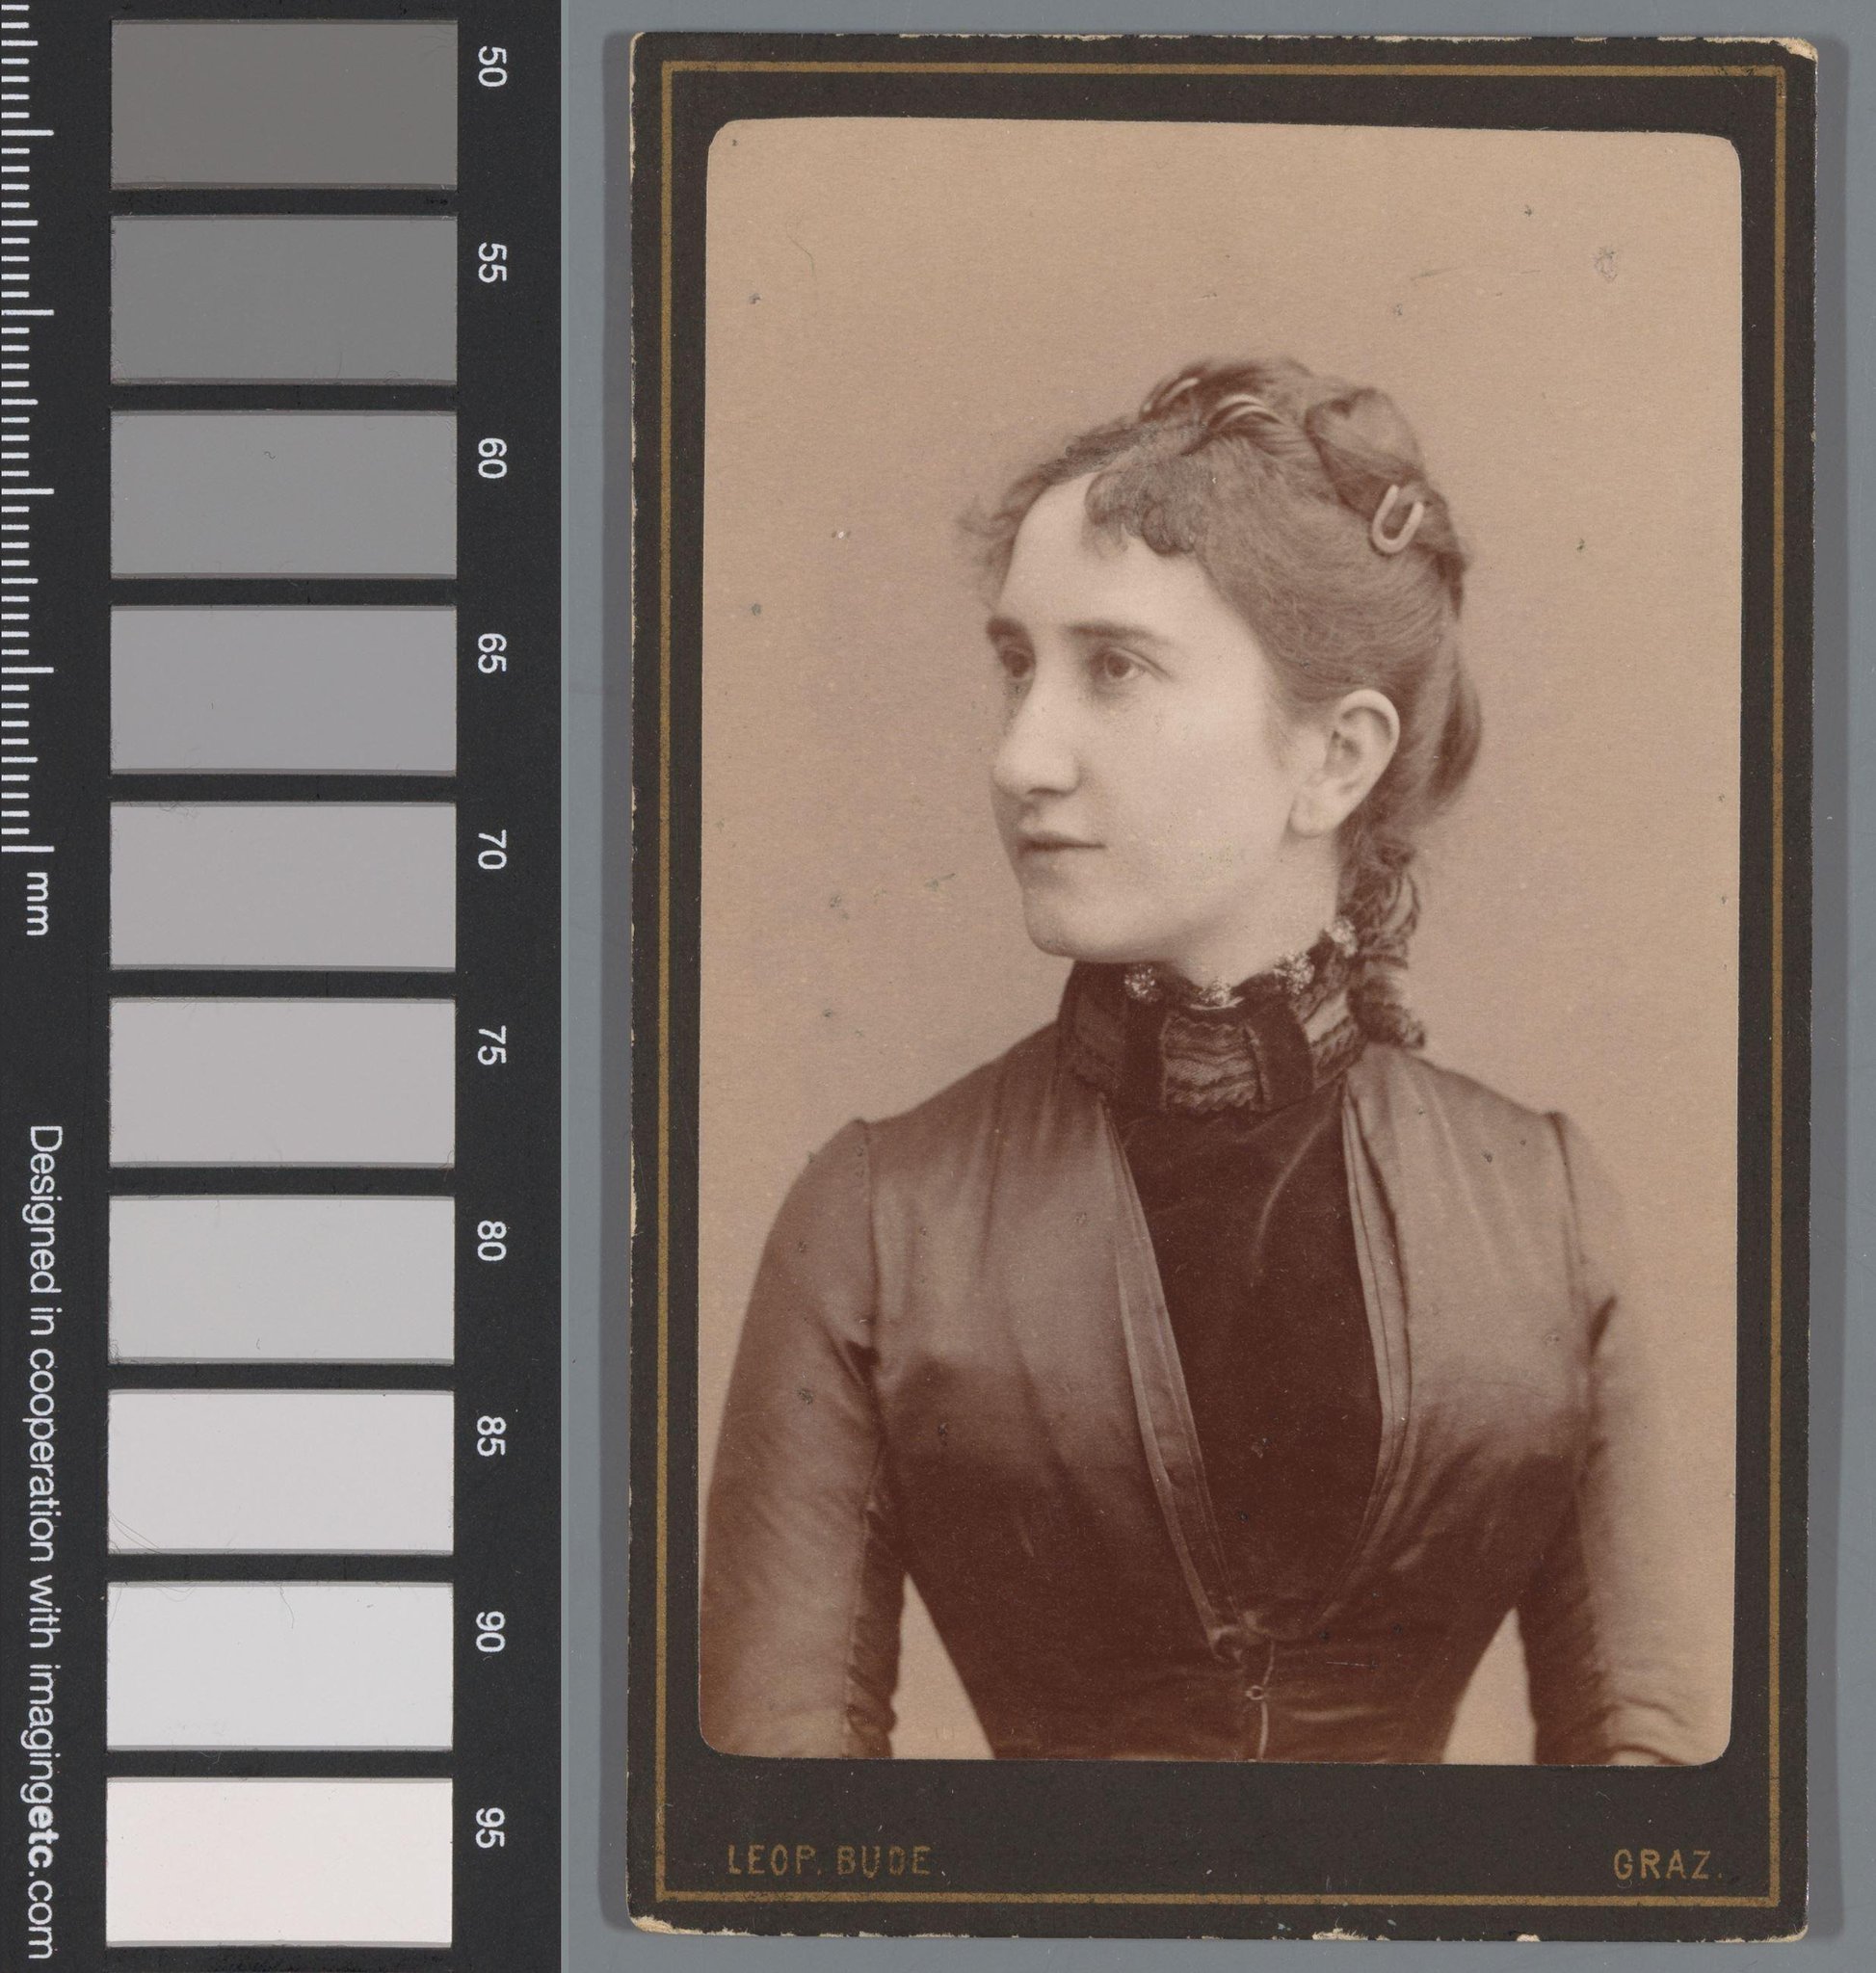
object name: photograph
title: Portret van een onbekende jonge vrouw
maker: leopold bude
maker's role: fotograaf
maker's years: 1840-1907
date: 1880-1907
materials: cardboard, paper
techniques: albumen print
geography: graz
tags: adolescent, young woman, maiden, anonymous historical person portrayed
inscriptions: inscription: ‘Ehren-/ Diplom des/ K.K. Museums/ für Kunst u./ Industrie/ Leopold Bude/ Chemiker & Fotograf/ Besitzer d. kais. gold. Med./ "Viribus Unitis"/ Graz/ Alleegasse 6/ vis à vis dem Stadttheater/ Medaillen:/ Paris 1878, Wien 1873, Pettau 1871, Graz 1870./ Diplome:/ Ehren-Diplom Graz 1880, Wien 1875, Graz 1869./ lit. K. Krziwanek, Wien.’, inscription: ‘Leop. Bude Graz.’